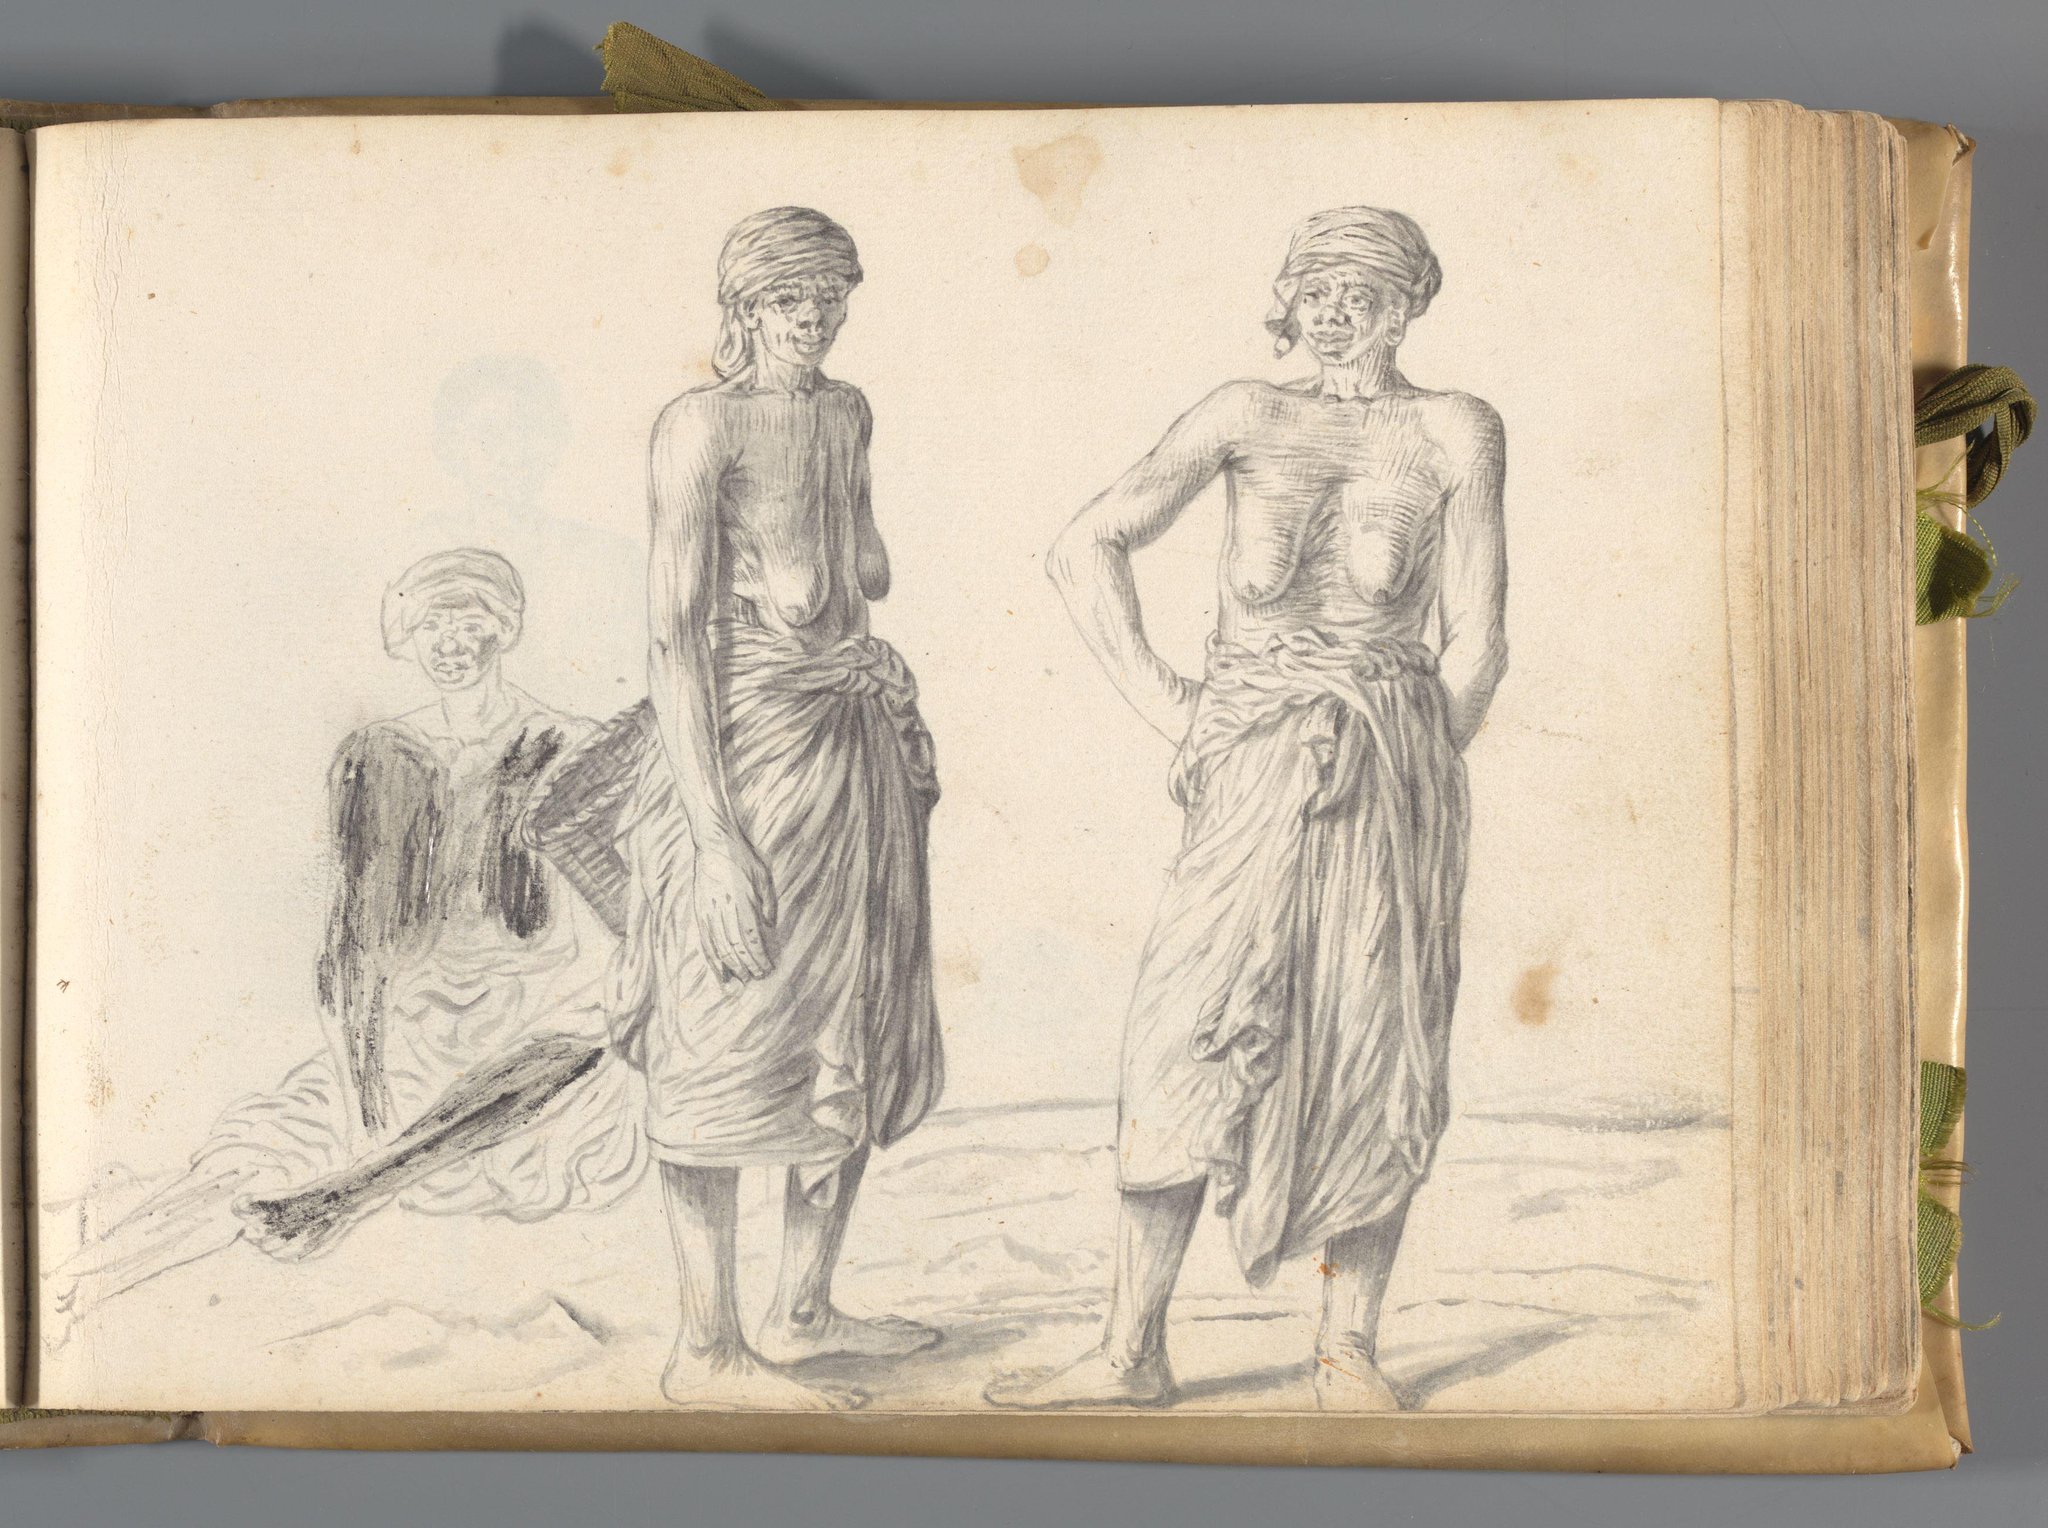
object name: sketchbook leaf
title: Three women labourers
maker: esaias boursse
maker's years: 1631-1672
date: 1662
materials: chalk, ink, paper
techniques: brush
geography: sri lanka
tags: africans, 41d232(...) skirt (lungi), working class, labourers - aa - women, sri lanka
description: Drie vrouwen met Afrikaanse trekken poseren buiten langs de weg voor de tekenaar. Vooraan staan twee vrouwen; een derde zit wat verder naar achter links op de grond. Ze dragen alle drie een omgeslagen heupkleed (lungi) dat tot de kuiten reikt en is vastgeknoopt in het middel. Het bovenlijf met hangborsten is onbedekt. Hun hoofden zijn bedekt met een omgeknoopte hoofddoek. De middelste vrouw draagt een mand. In de tekening van de zittende vrouw zijn – waarschijnlijk later – een arm, de borsten en een been bijgewerkt met zwart krijt. Blad 18 uit een schetsboek met 117 bladen.